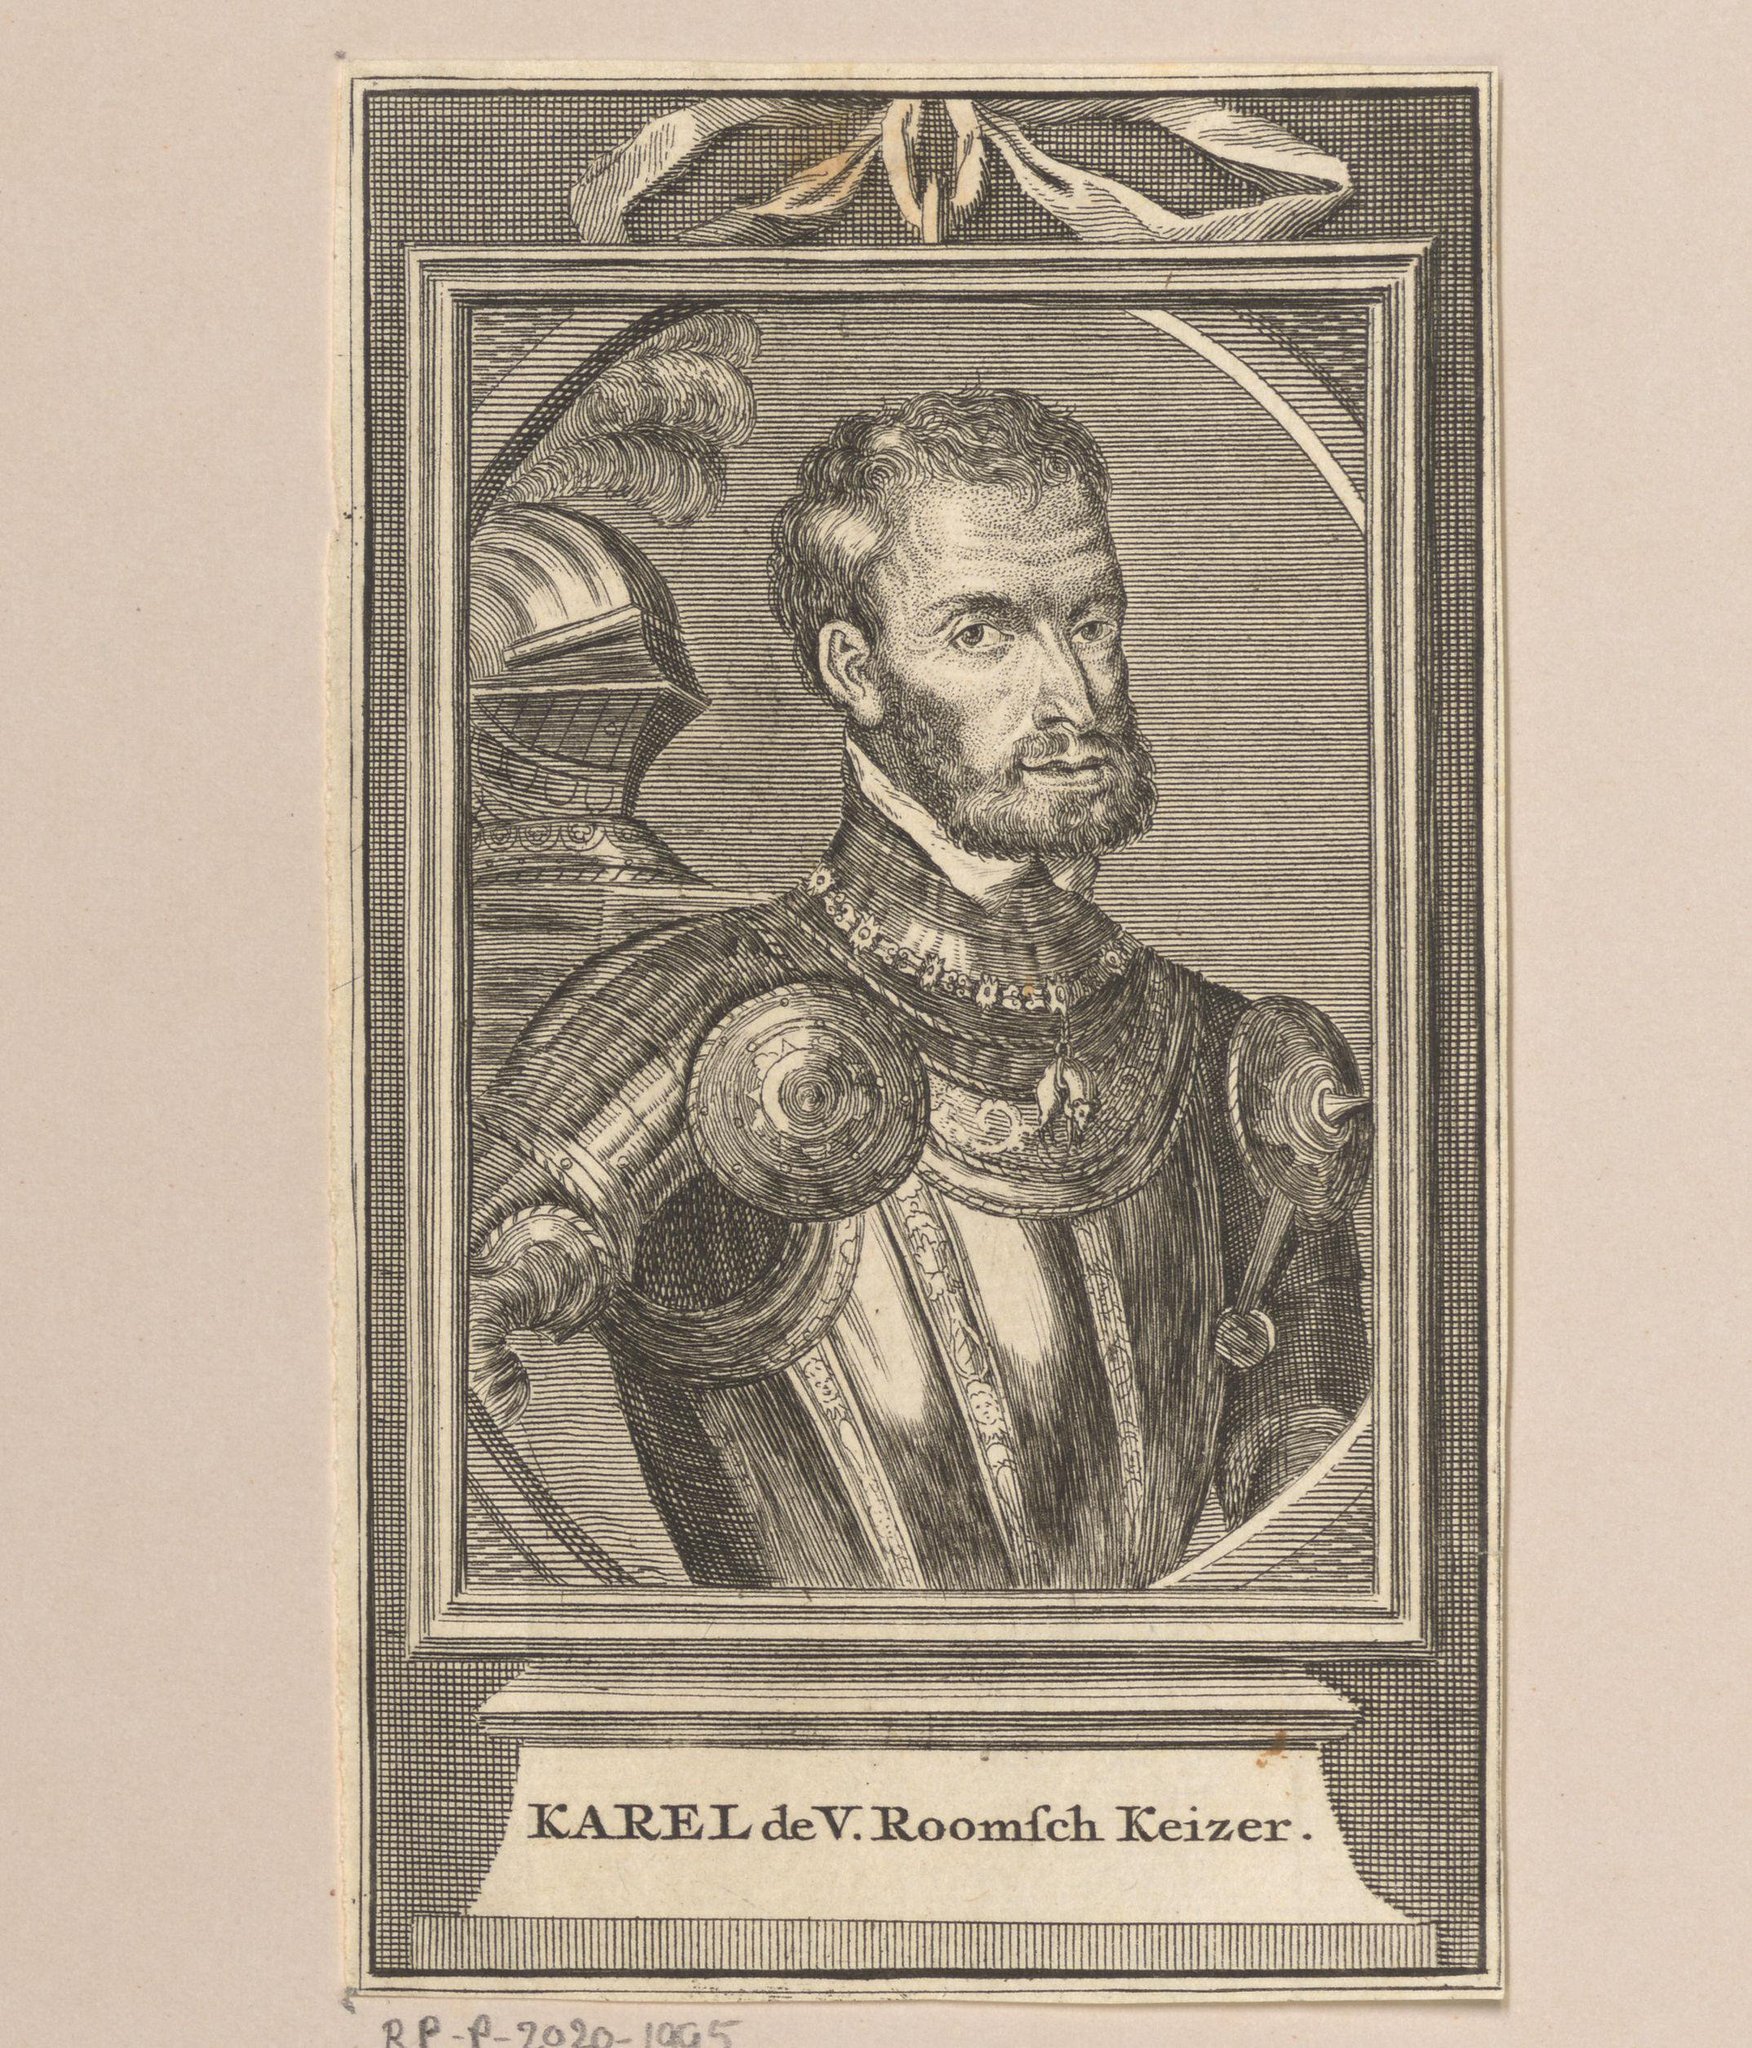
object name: print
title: Portret van keizer Karel V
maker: Anonymous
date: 1735-1738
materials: paper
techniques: engraving, etching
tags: ghent, charles v (holy roman emperor and king of spain), historical persons, knighthood order of the golden fleece, king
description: Prent mogelijk uit: Leti, Gregorio. Het leven van keizer Karel, den Vyfden. Amsterdam: Johannes de Ruiter, 1735, dl. 1. Of uit een latere publicatie (1738).